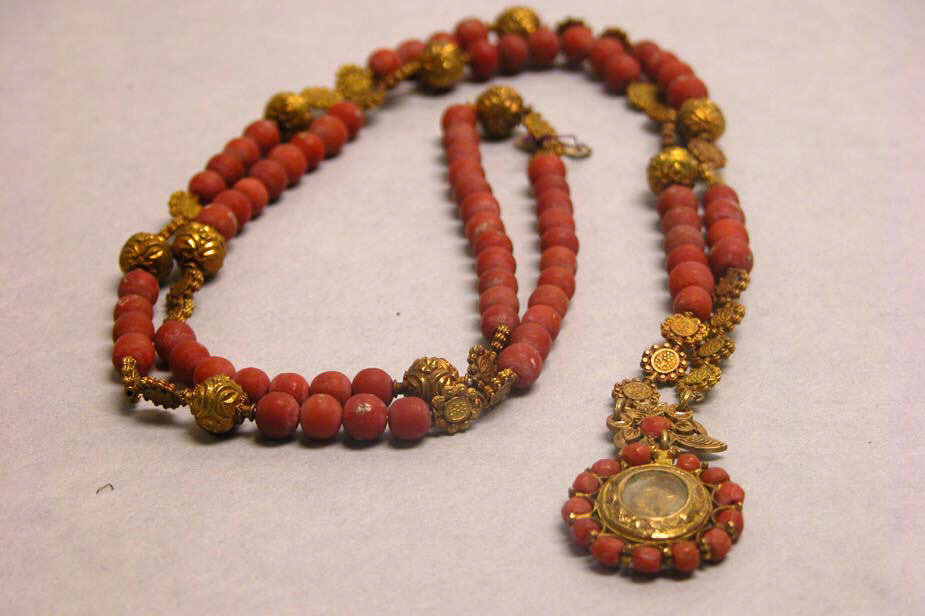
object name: necklace or rosary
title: Necklace or Rosary (?)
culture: filipino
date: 1601-1900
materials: coral, gold